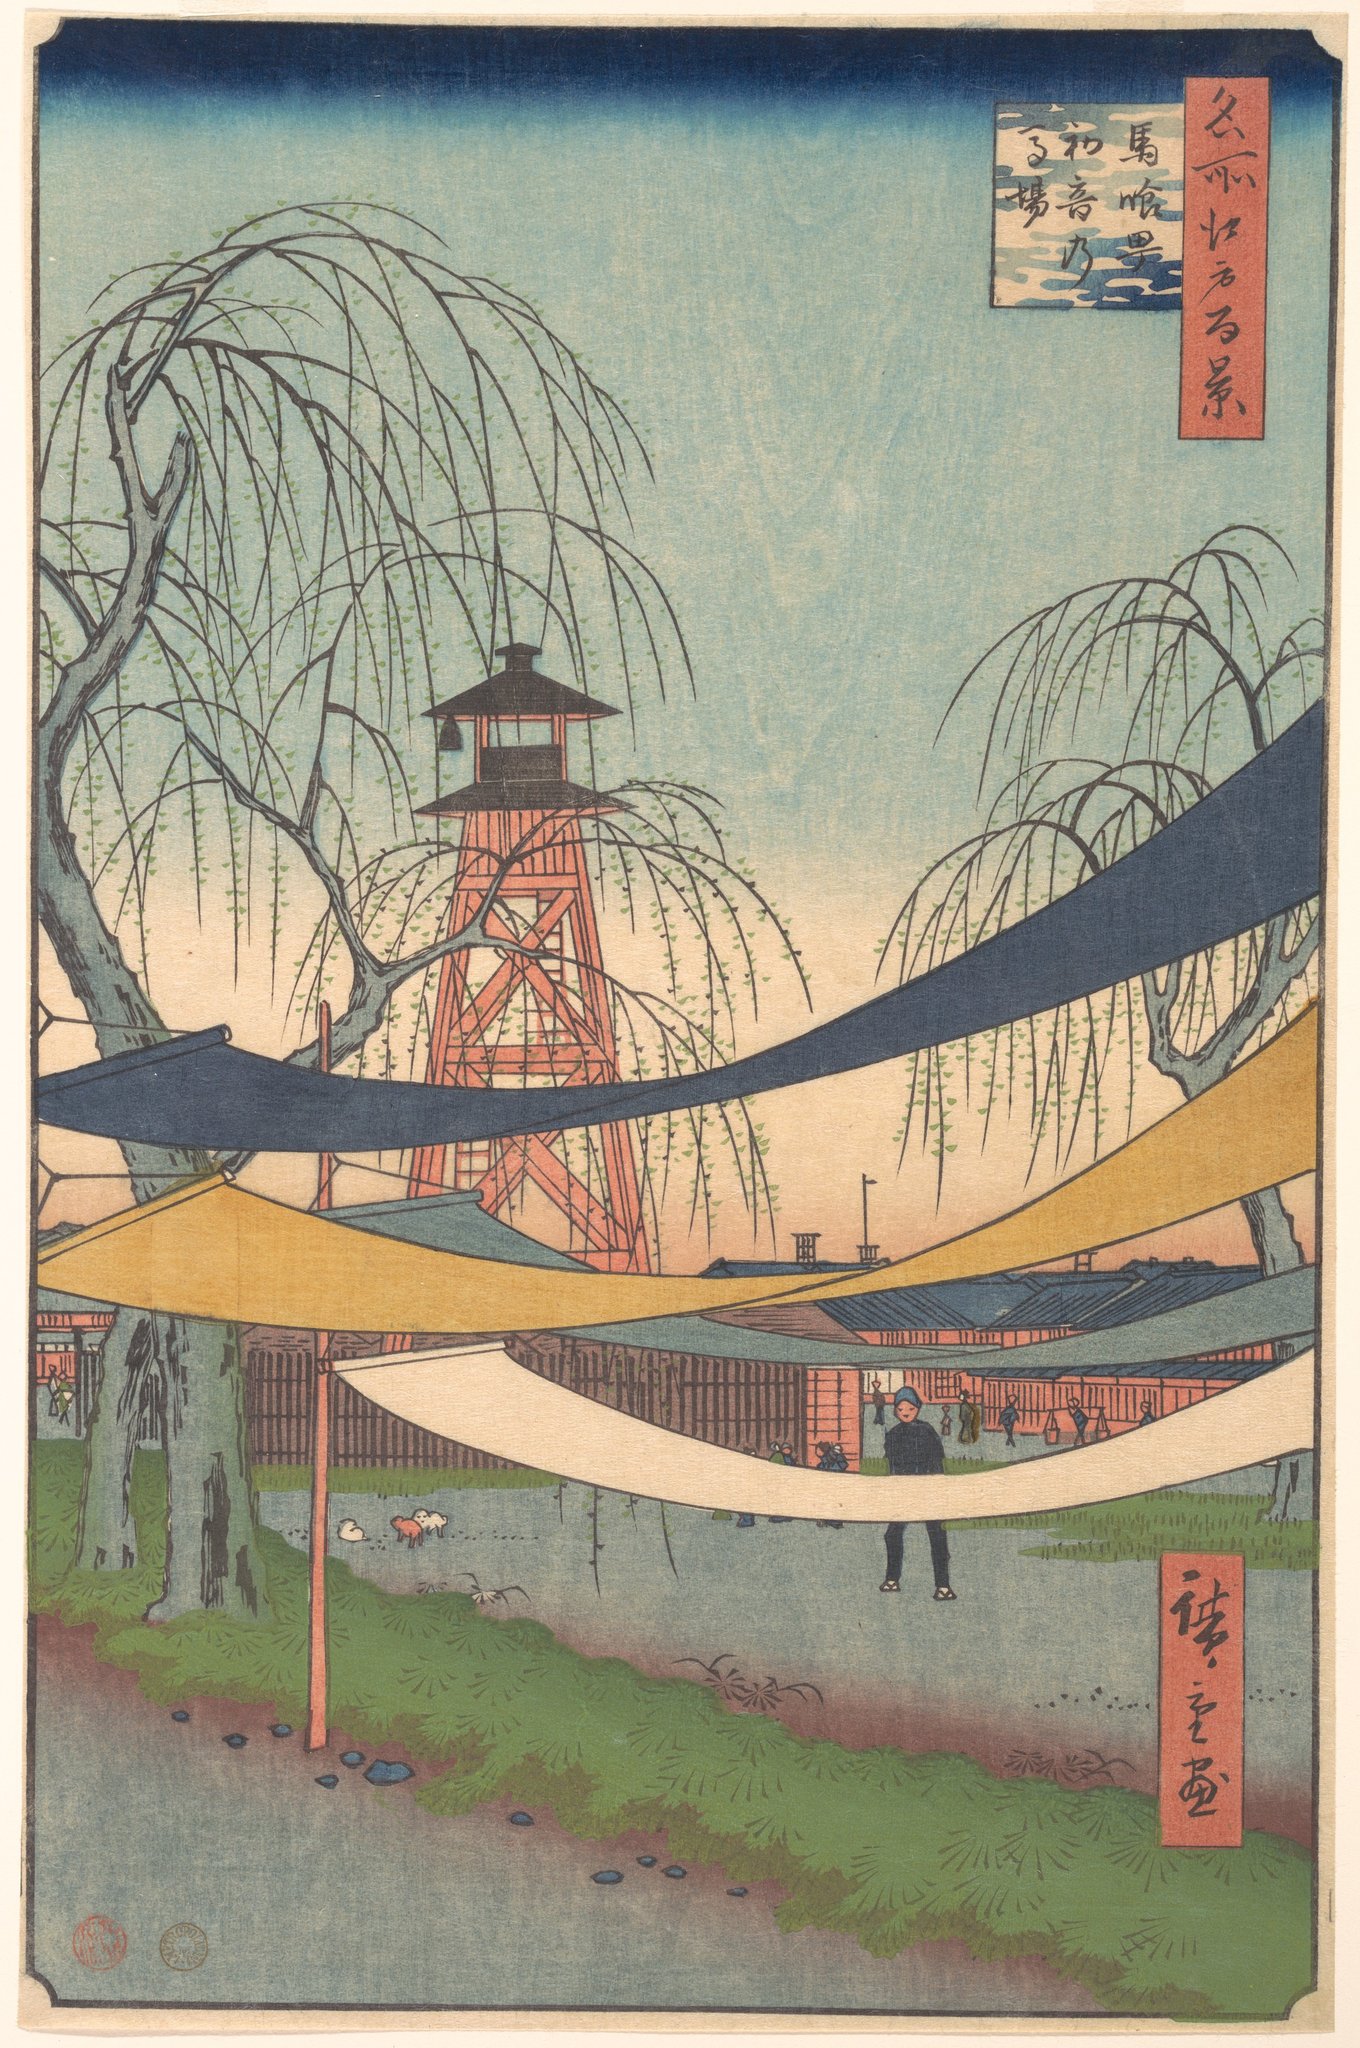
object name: print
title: Hatsune no Baba; Bakurocho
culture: japanese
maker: utagawa hiroshige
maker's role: artist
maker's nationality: japanese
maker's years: 1797-1858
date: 1857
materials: ink, paper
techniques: woodblock print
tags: towers,men,trees